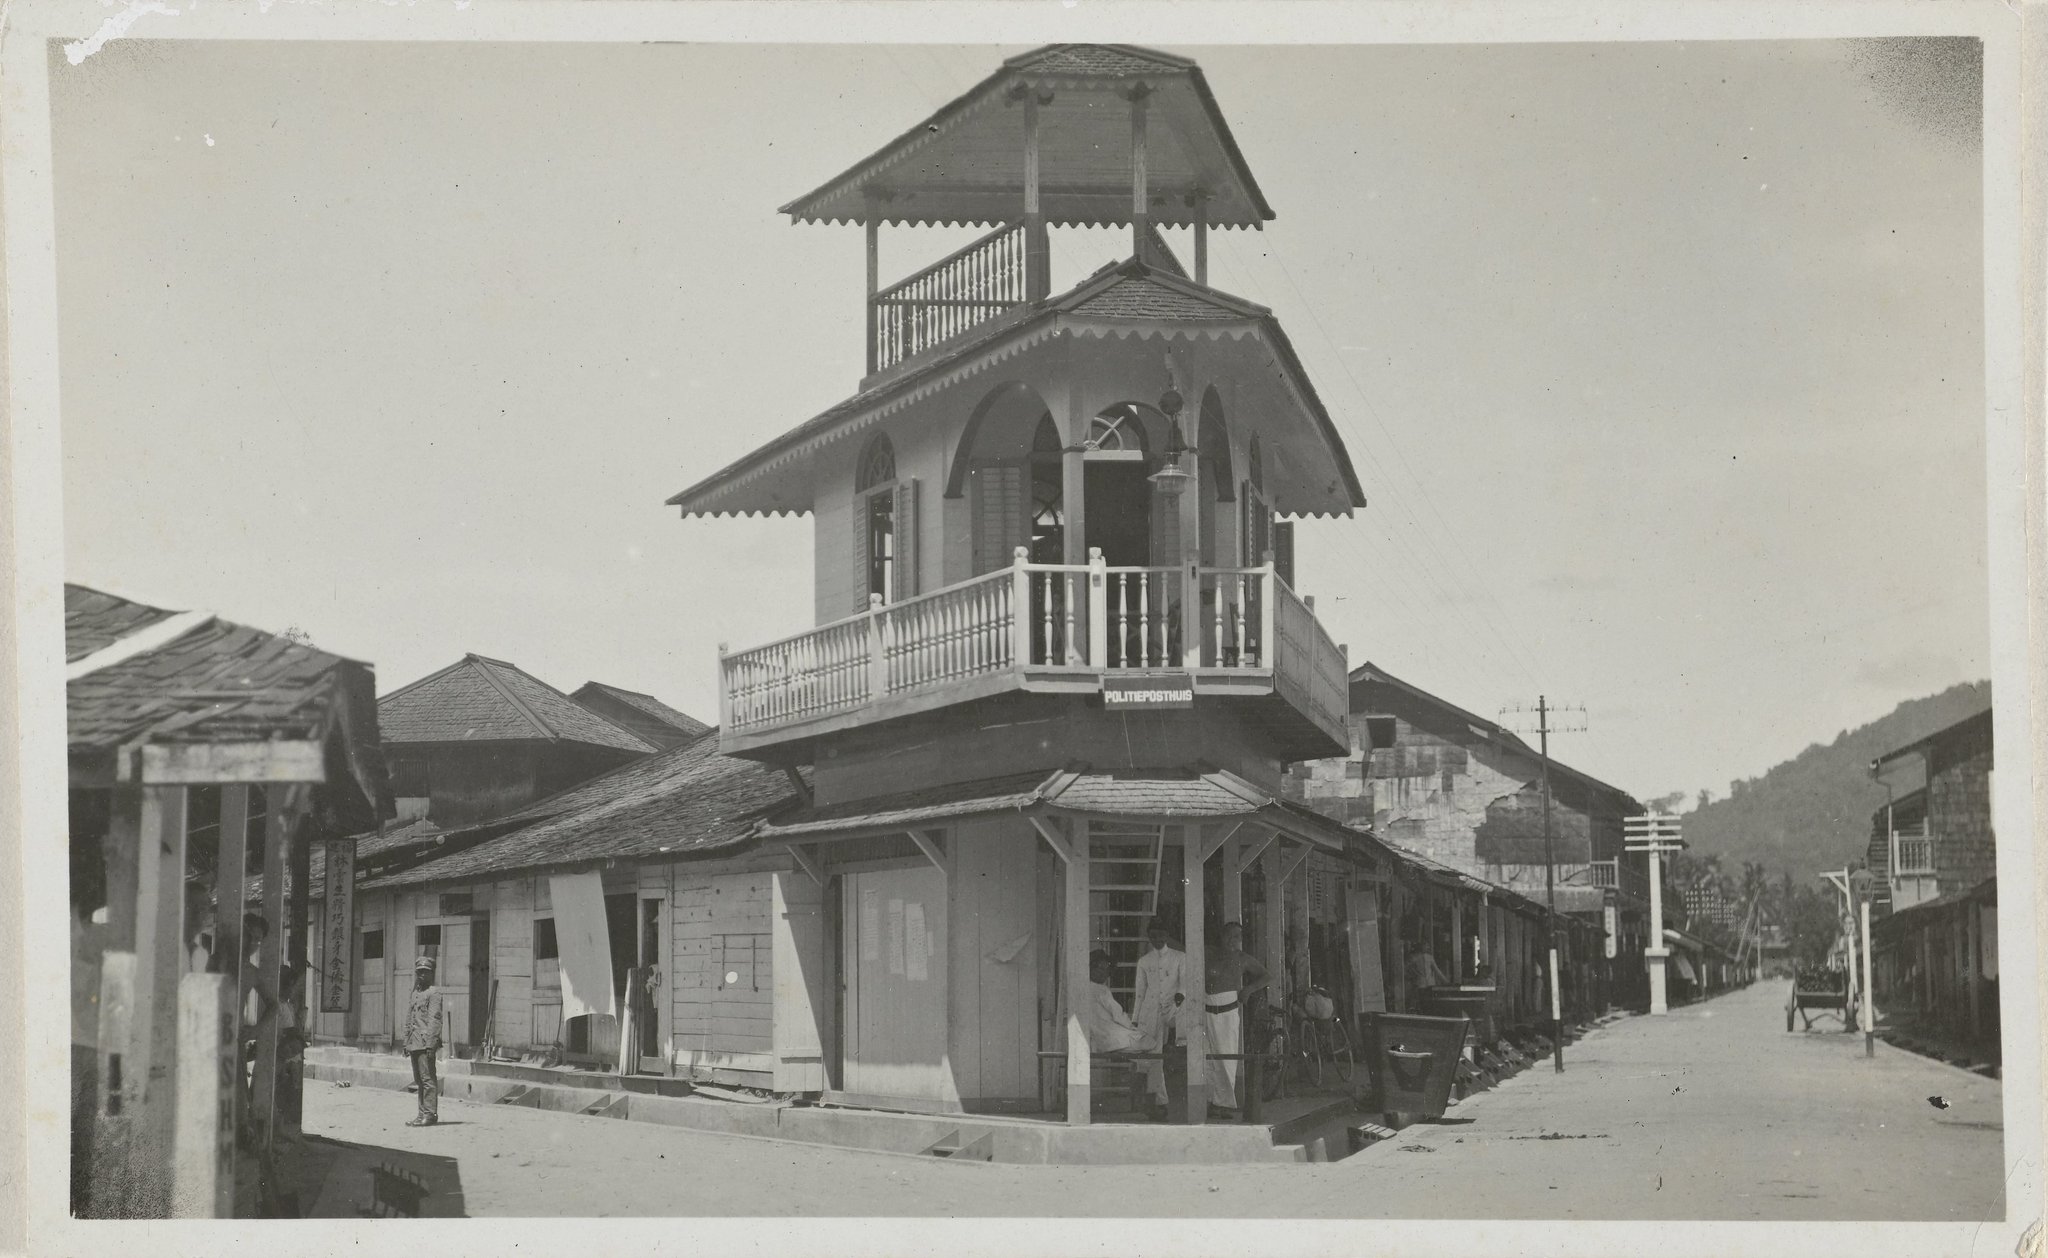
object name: photograph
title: Straatgezicht in Singkawang met hoekwoning met terras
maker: Anonymous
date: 1920-1940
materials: photographic support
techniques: gelatin silver print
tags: borneo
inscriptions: annotation: ‘Post card, correspondence address only’